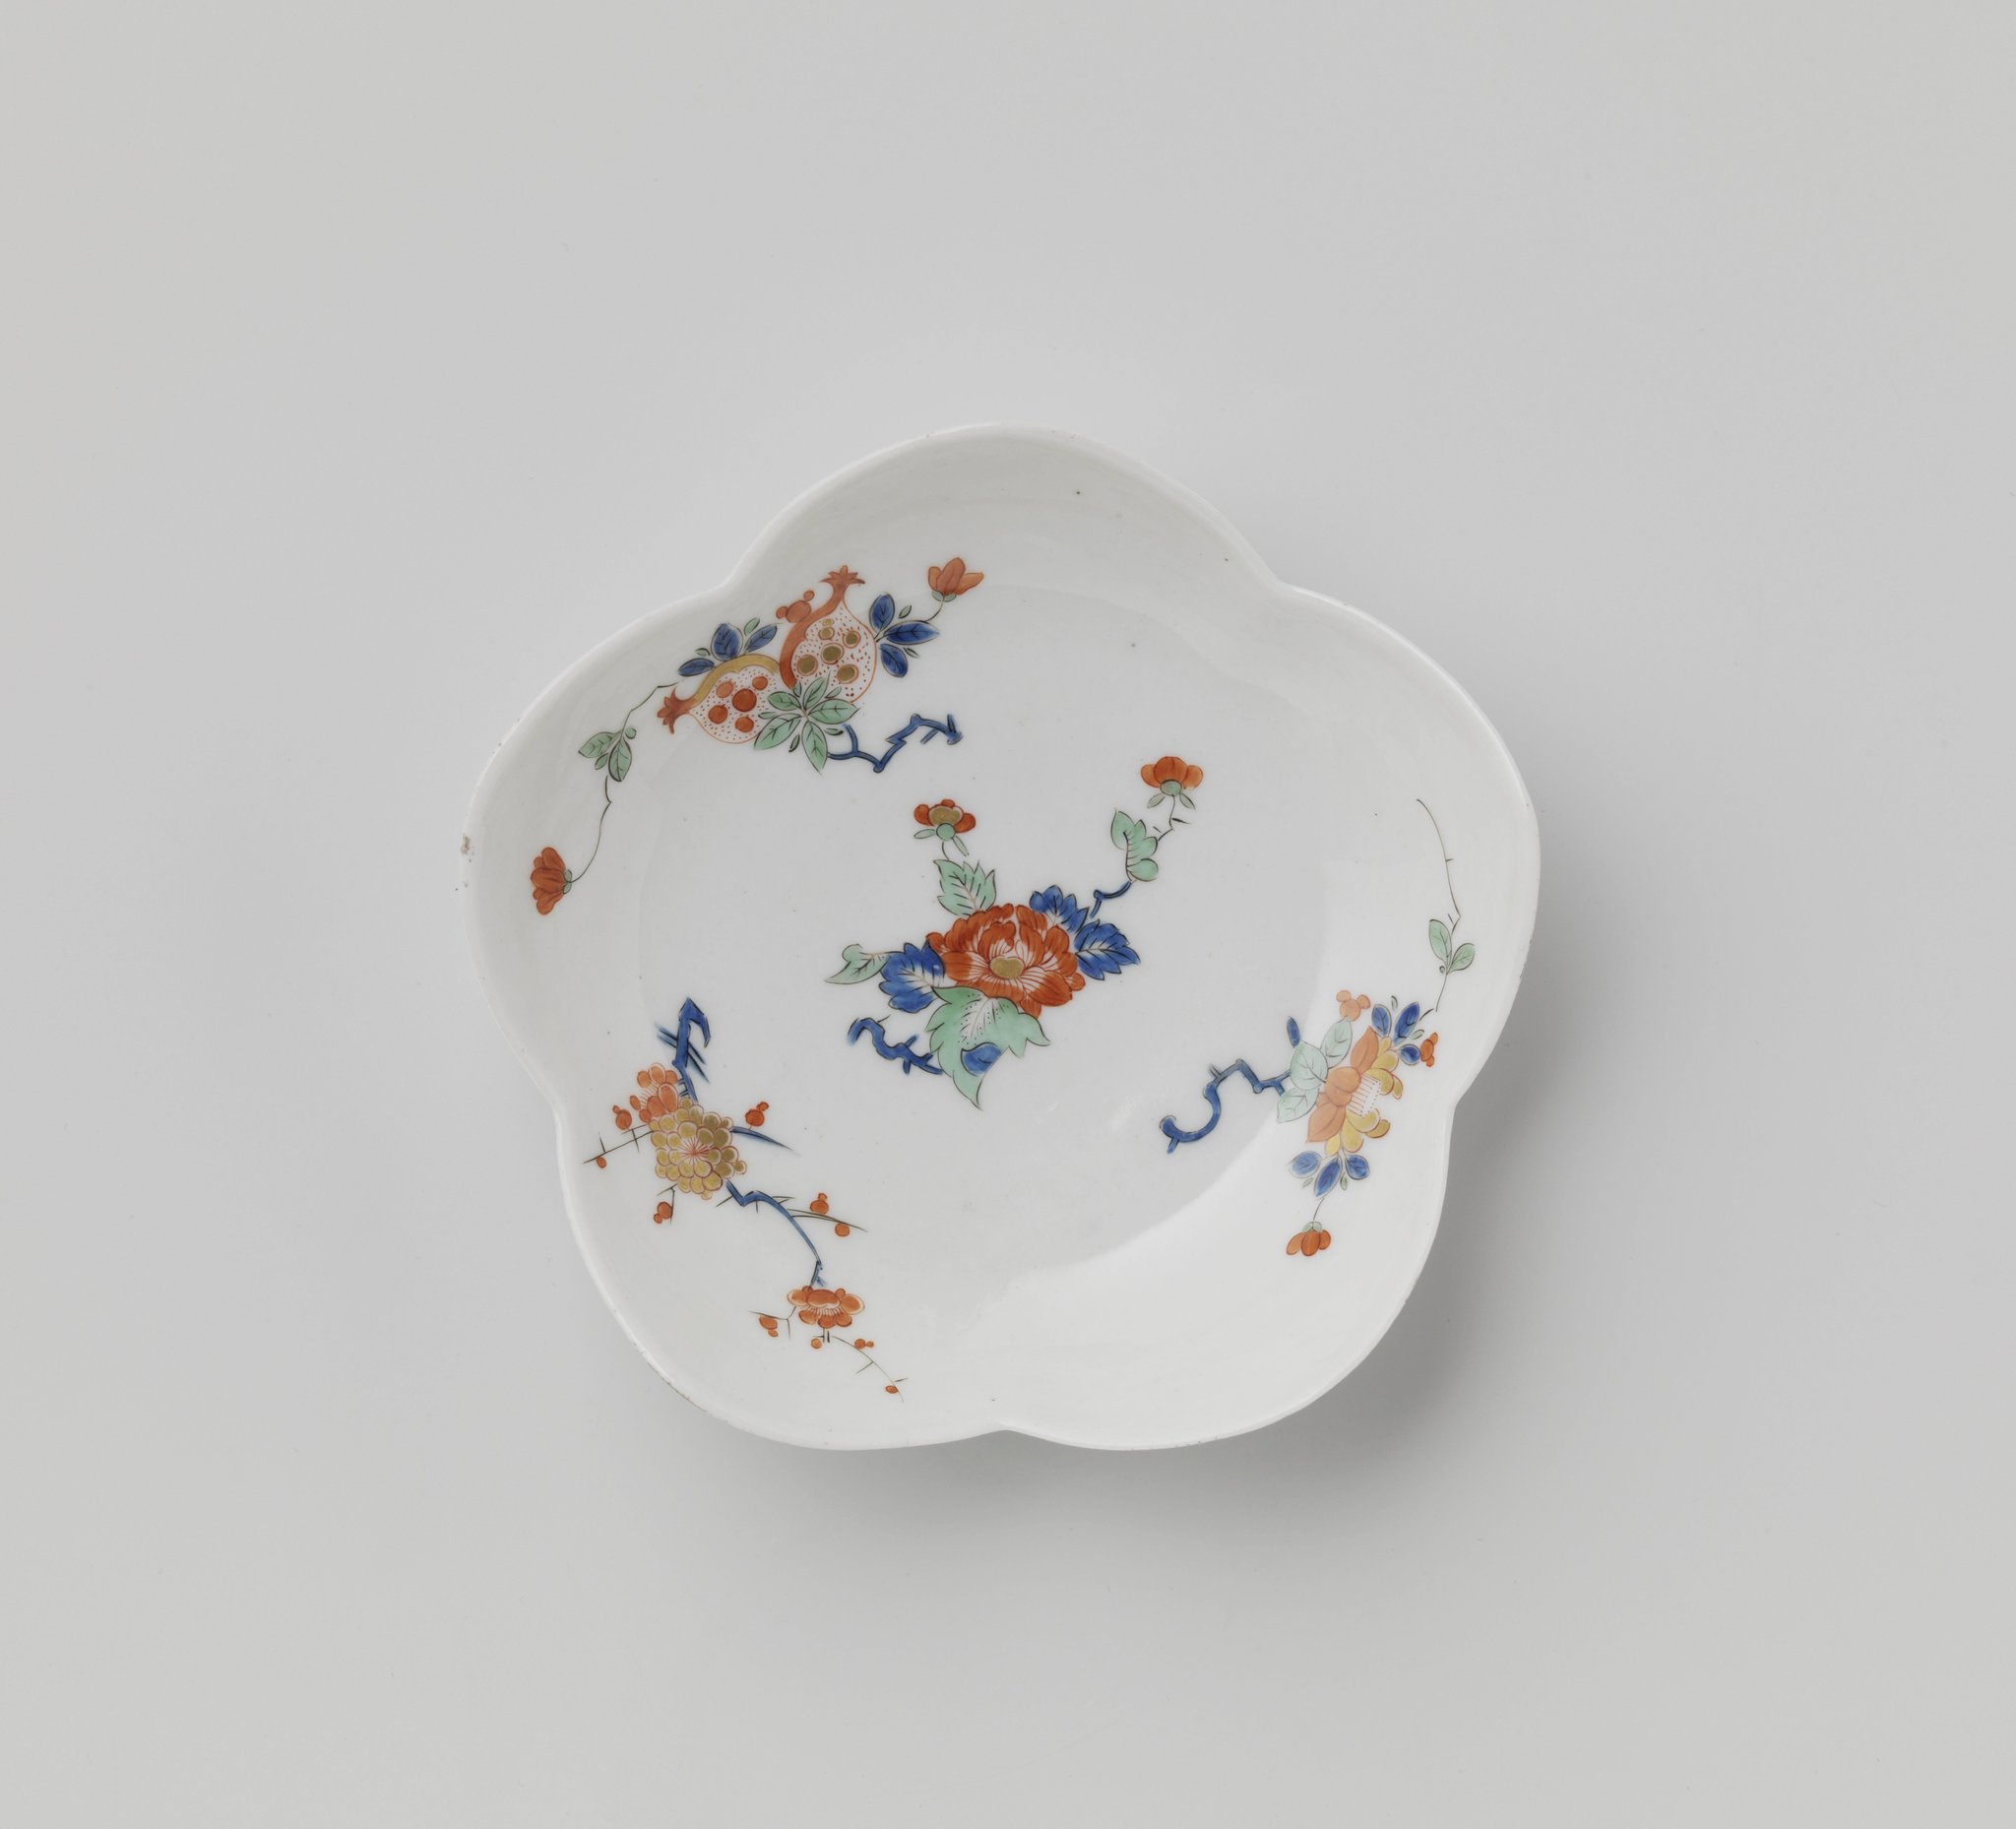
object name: eating drinking utensil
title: Schotel voor een chocoladekop, veelkleurig beschilderd met een Kakiemon-decor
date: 1730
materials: porcelain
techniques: painted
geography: meissen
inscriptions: factory mark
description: Saucer Meissen, c. 1725 - 1735 From the collection of August the Strong of Saxony, with the Dresden Palace inventory number N=338